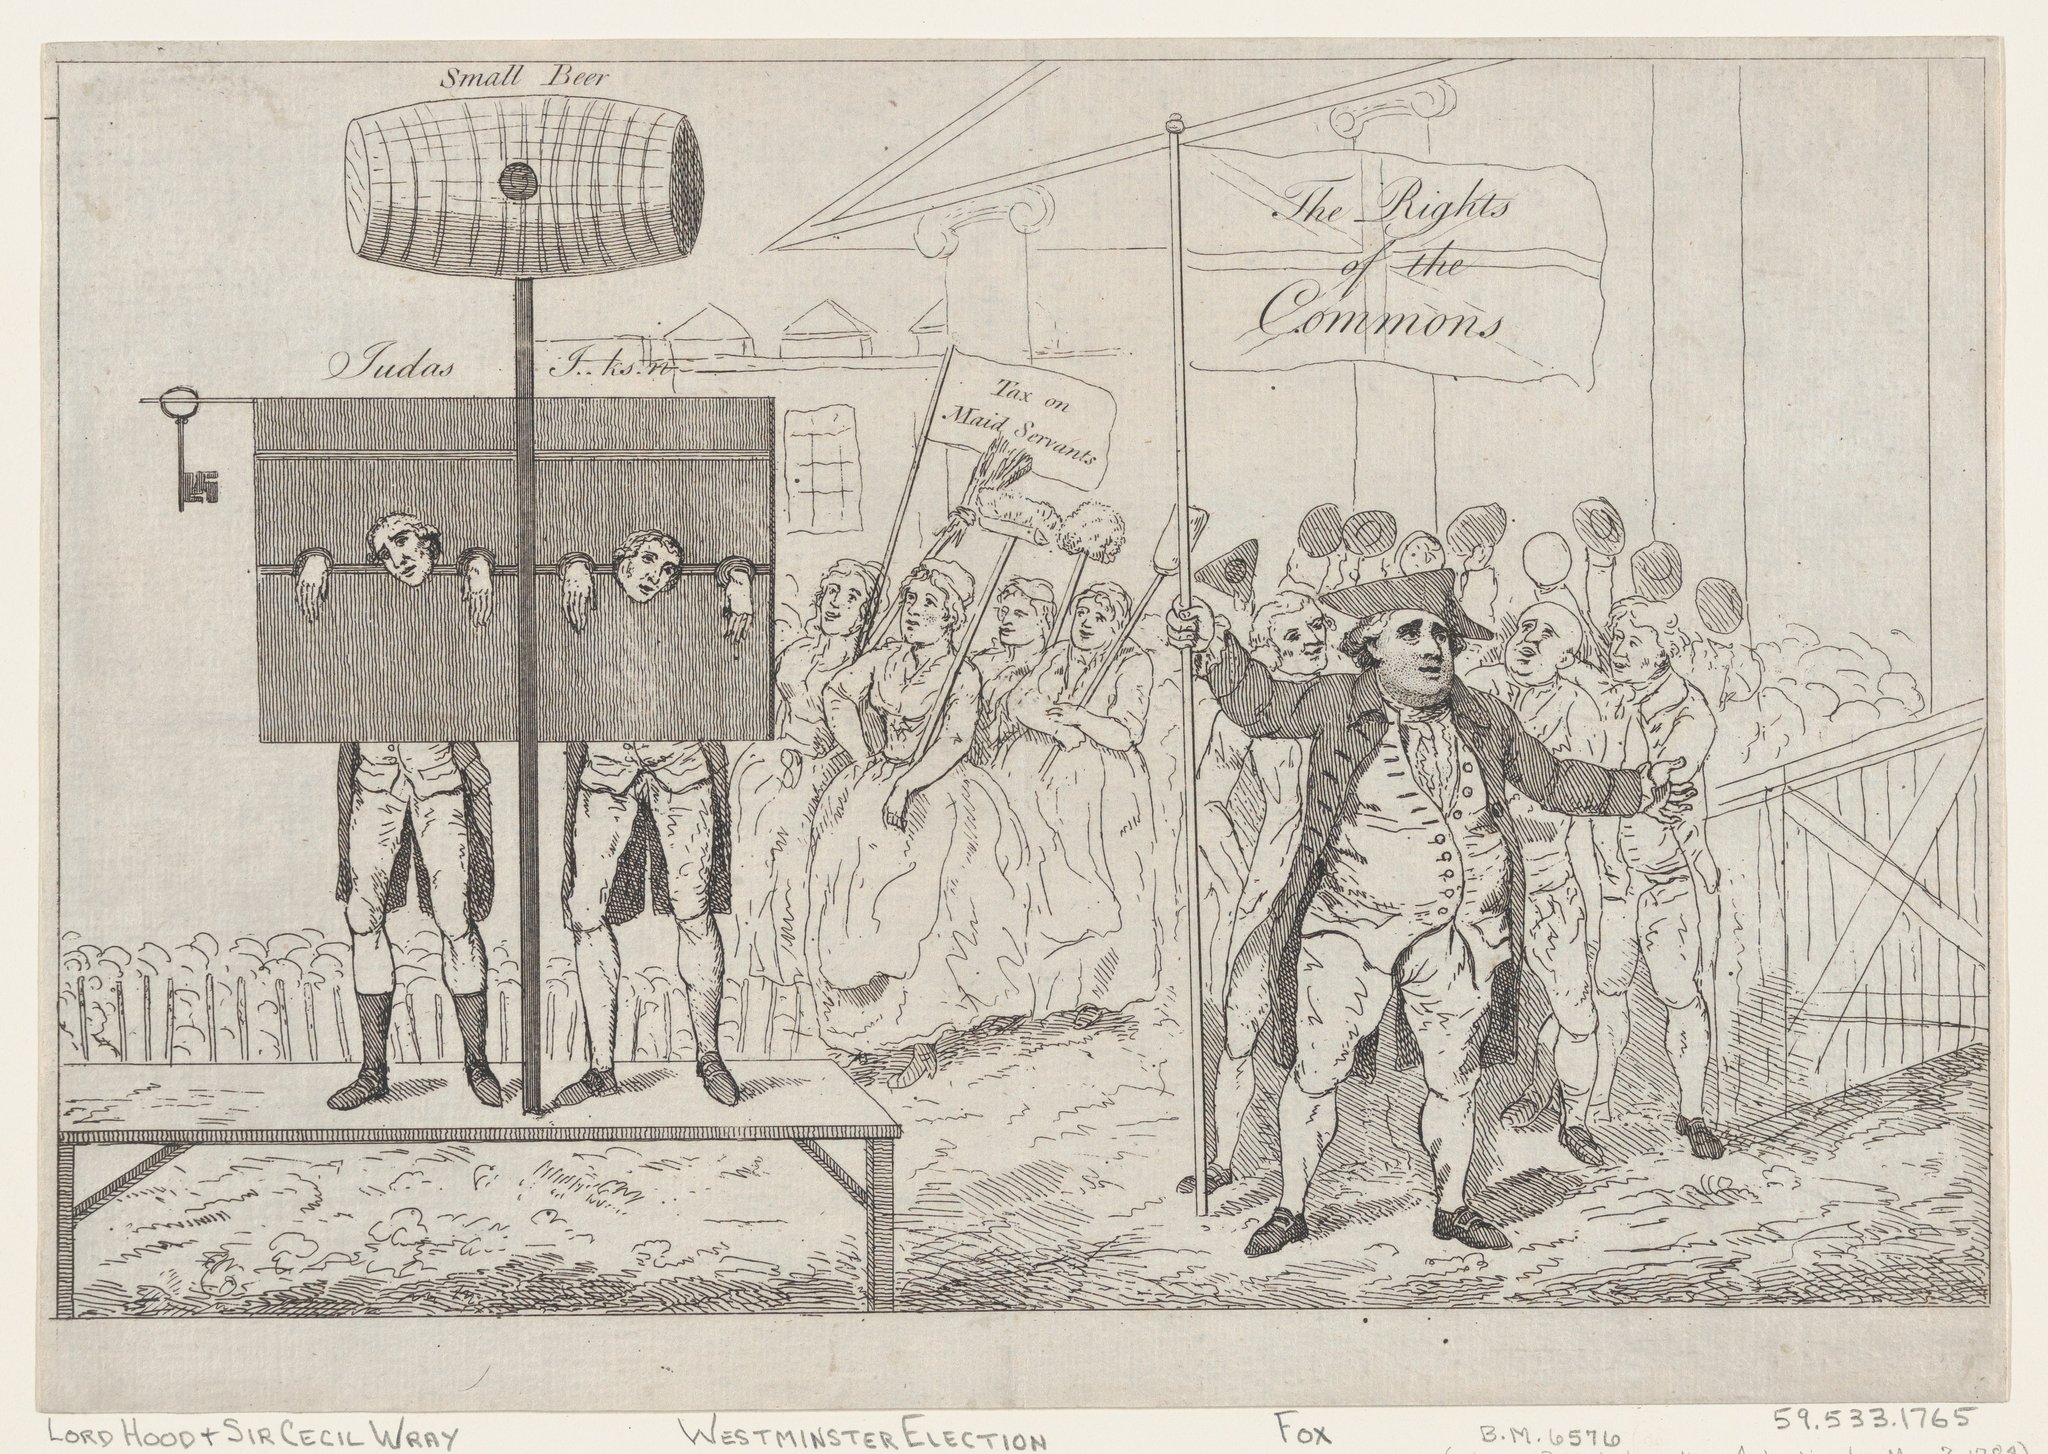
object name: print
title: Sir Cecil Wray in the Pillory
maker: thomas rowlandson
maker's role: artist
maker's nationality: british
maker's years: 1757-1827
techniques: etching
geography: london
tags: men,women,punishment